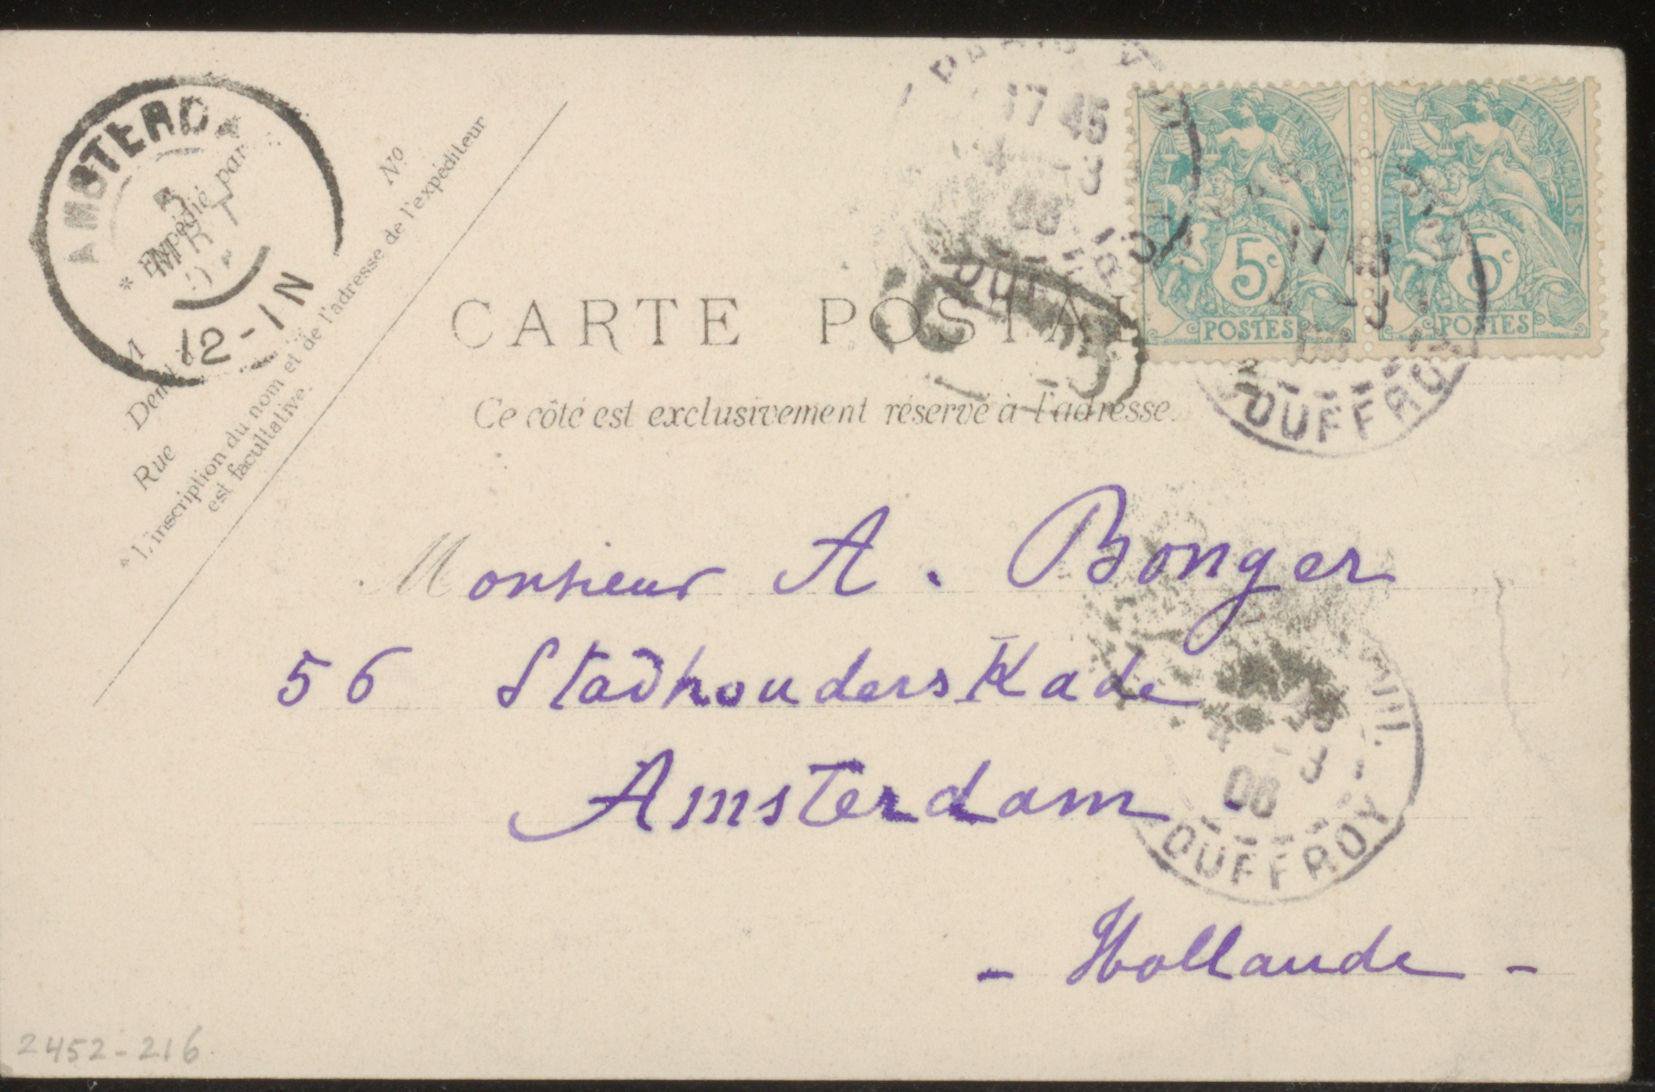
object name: ansichtkaart, prentbriefkaart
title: Prentbriefkaart aan Andries Bonger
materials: cardboard, ink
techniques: photograph, pen, writing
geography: paris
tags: andries bonger, robert schumann, amsterdam, artist, willem jan gerrit van meurs, photography, cinematography